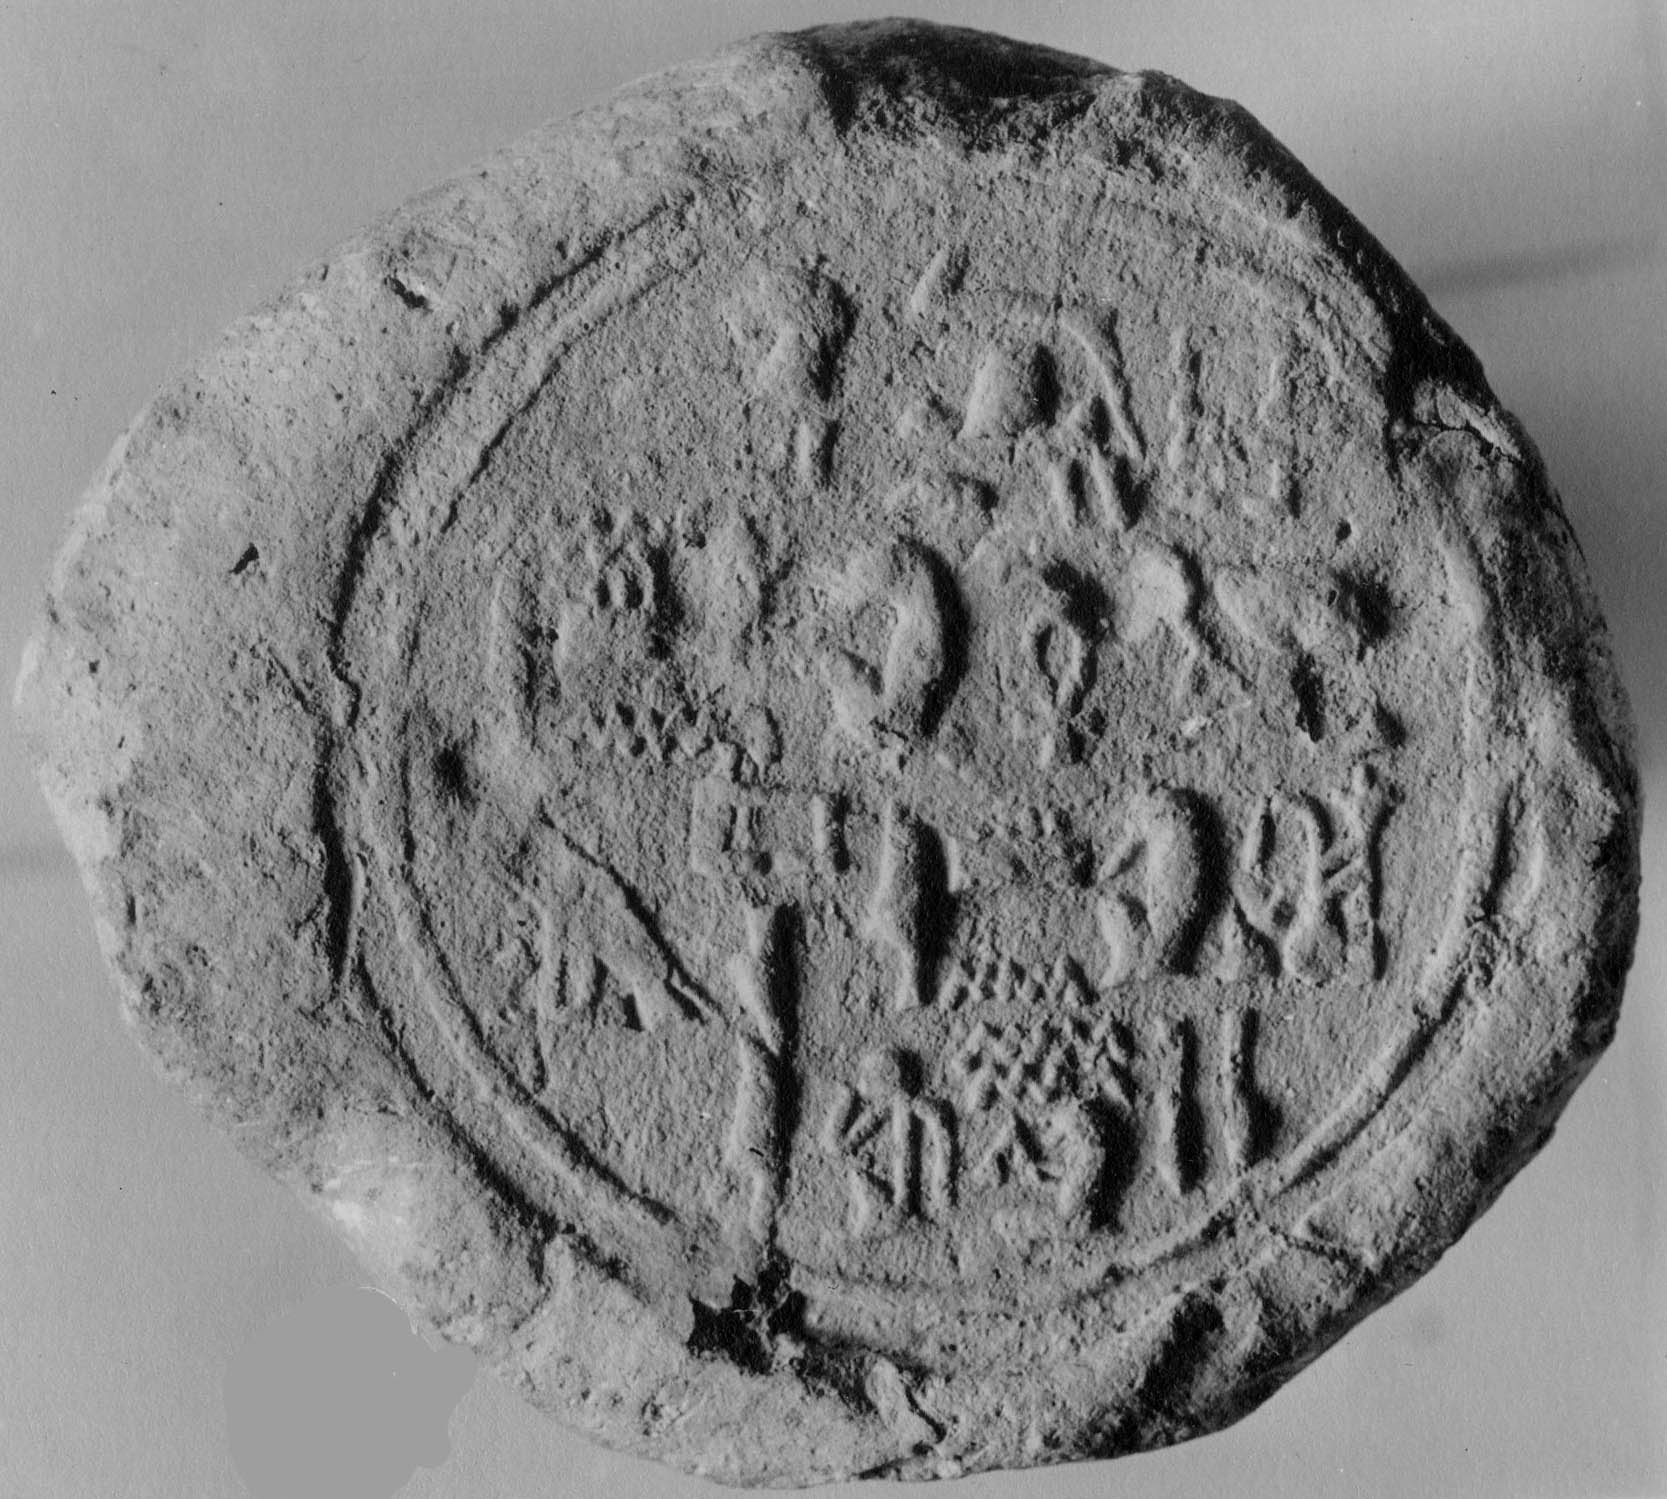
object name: cone, circular impression, ineni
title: Funerary Cone of Ineni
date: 1550-1295 BCE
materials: pottery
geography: egypt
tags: hieroglyphs